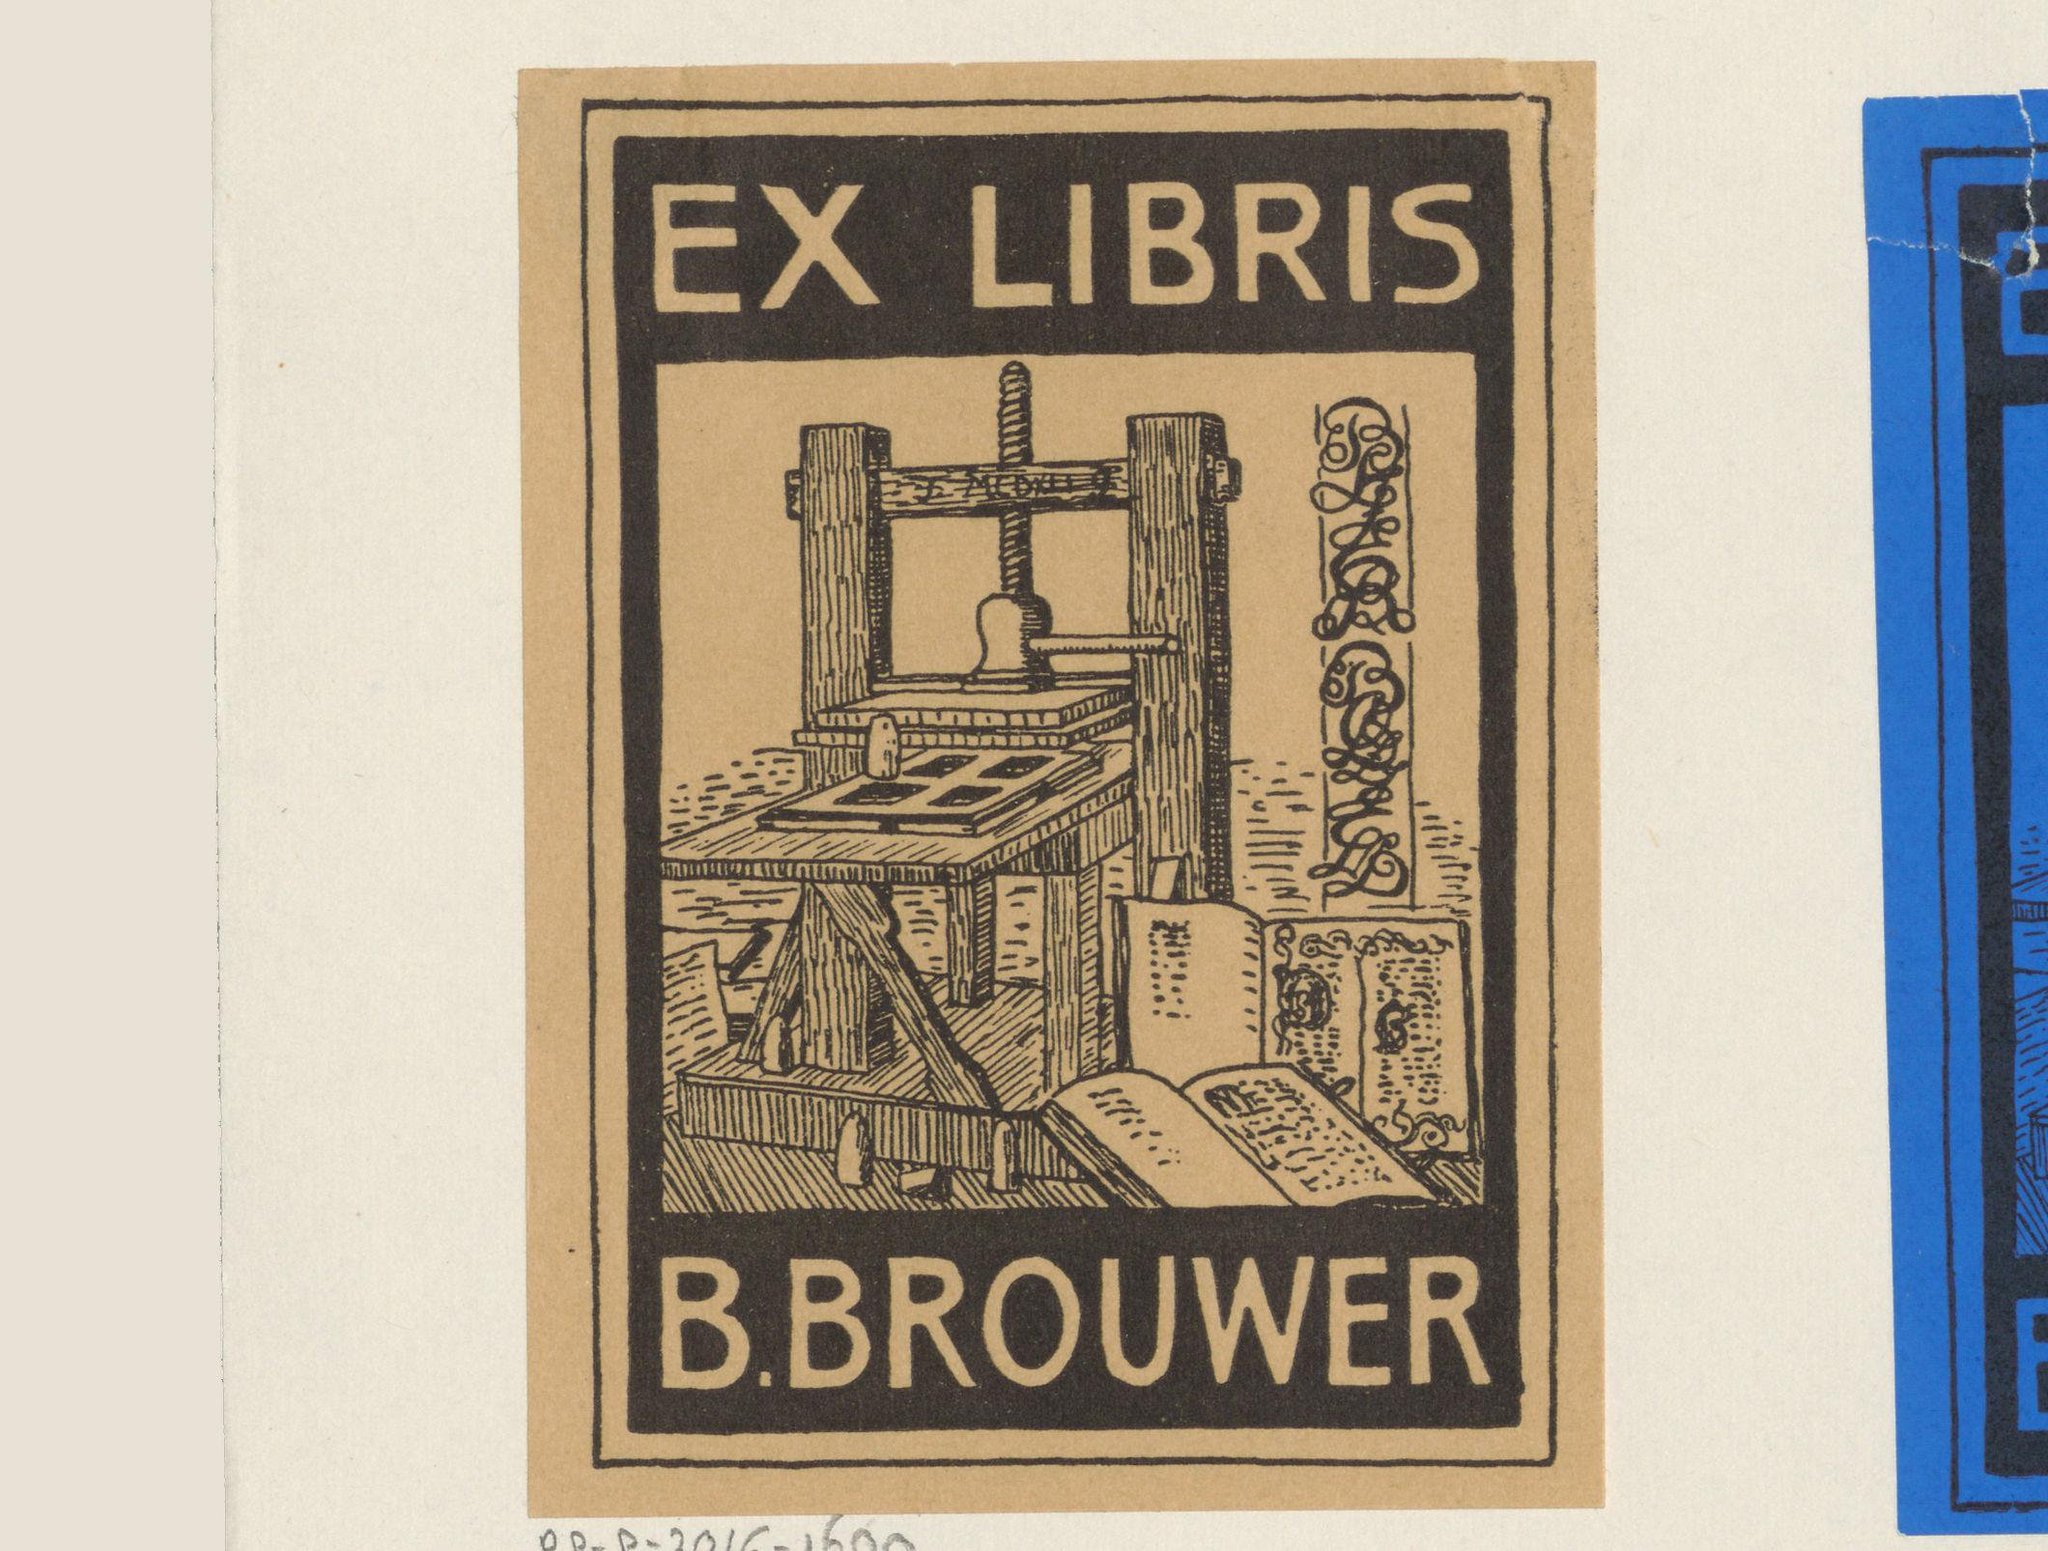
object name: bookplate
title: Ex libris van B. Brouwer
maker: Anonymous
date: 1900-1999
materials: paper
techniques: printing block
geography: groningen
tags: printer, printing press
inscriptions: inscription: ‘B. Brouwer Groningen’